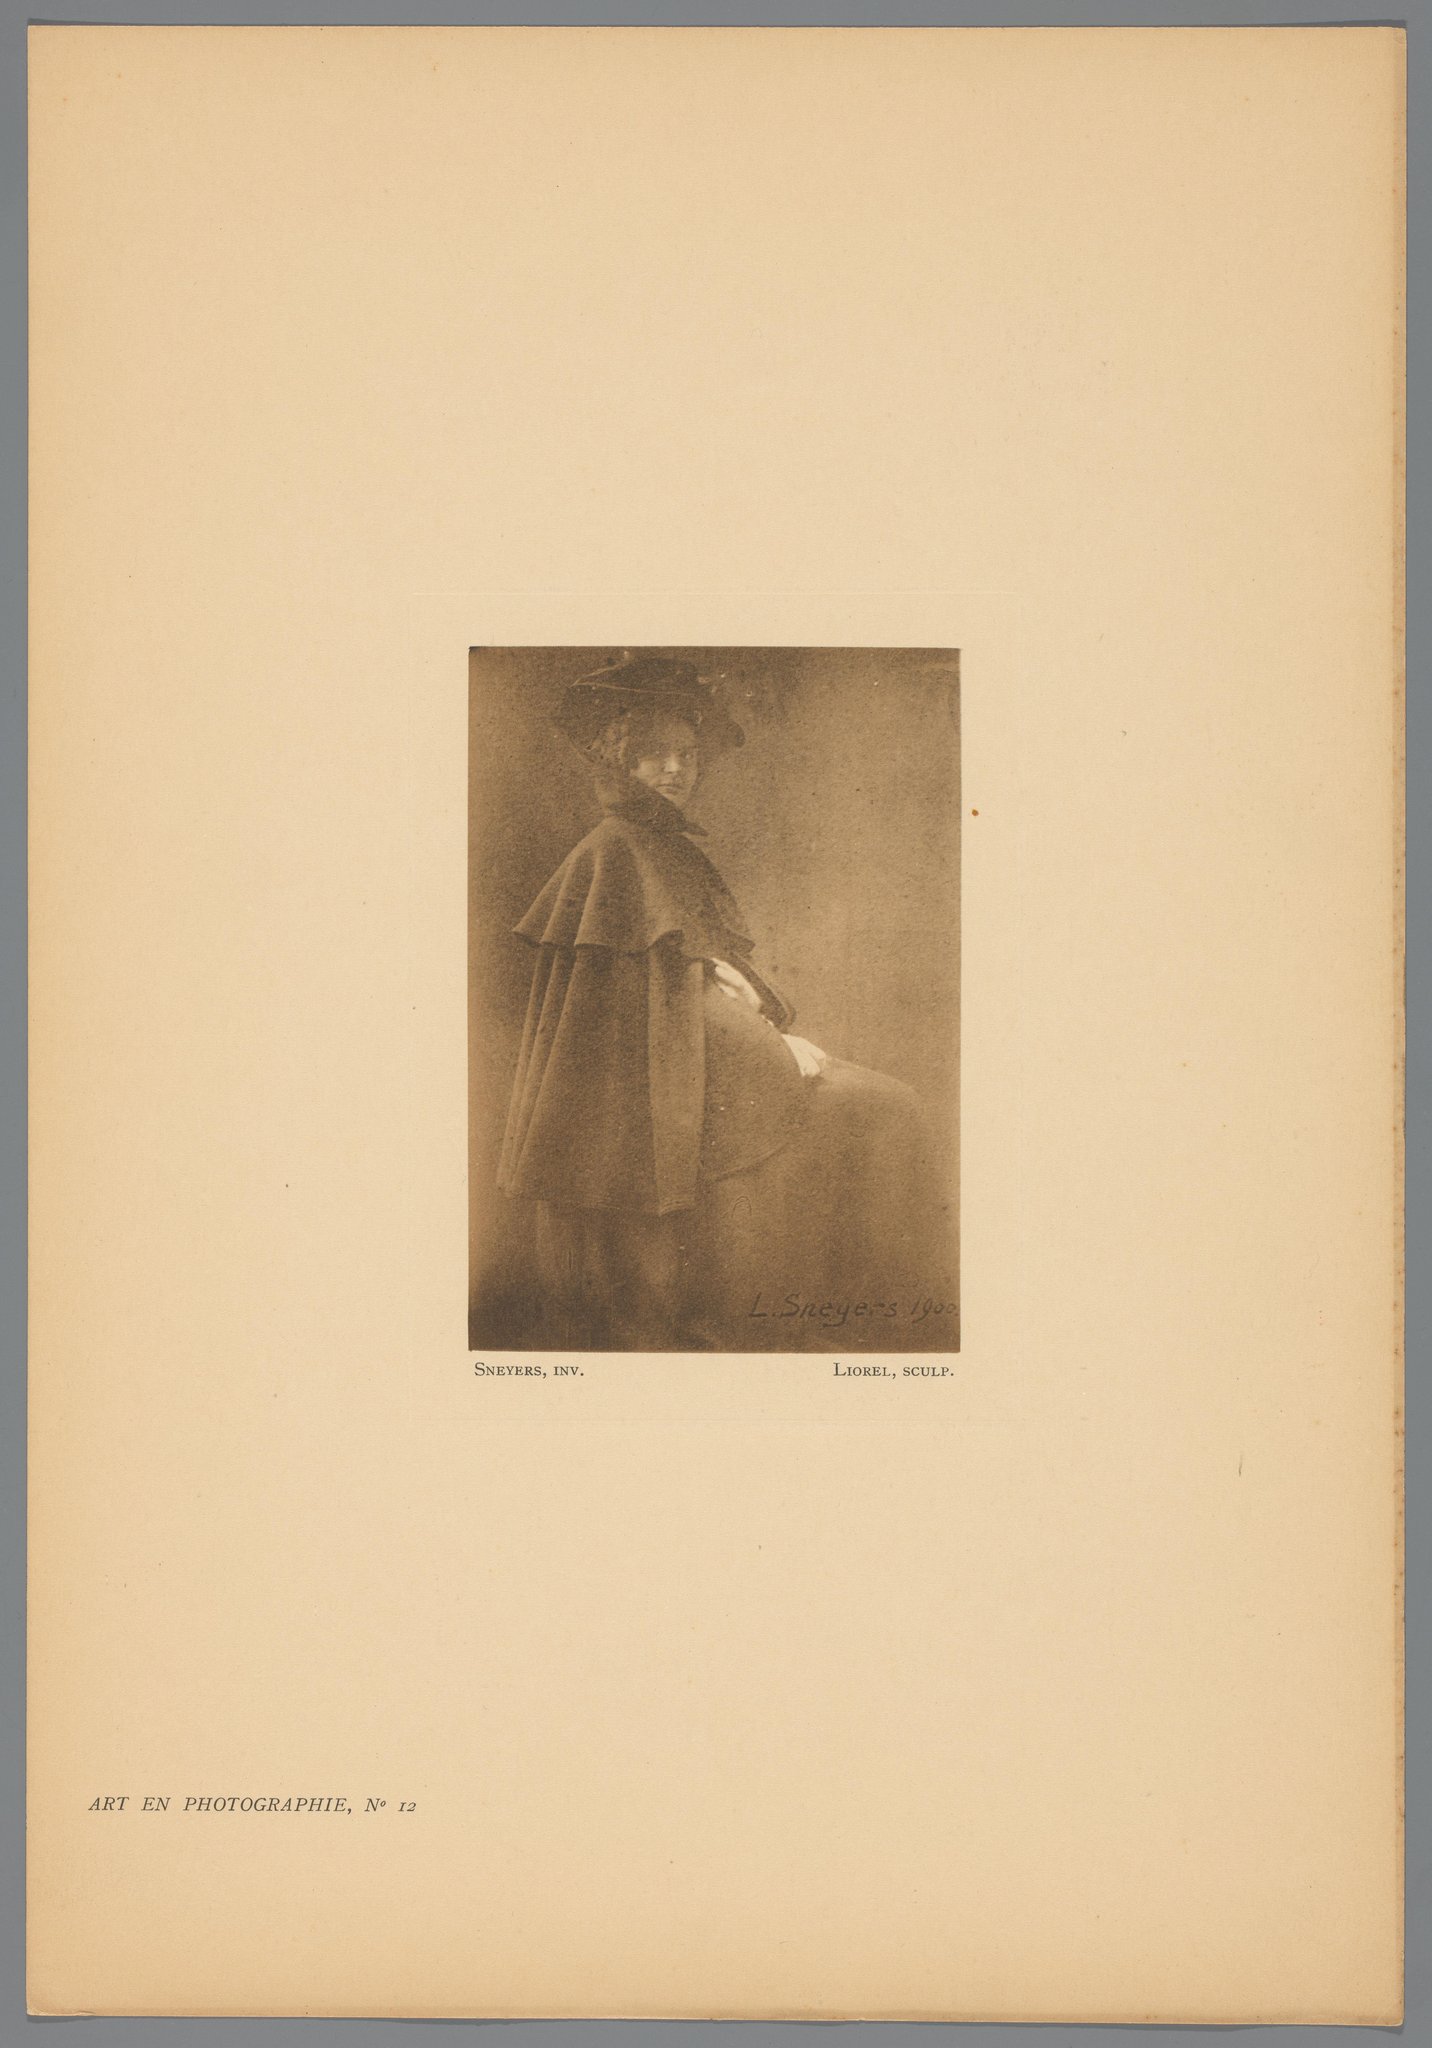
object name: photomechanical print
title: Portret van een onbekende vrouw in een mantel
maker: léon sneyers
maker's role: architect, fotograaf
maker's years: 1877-1949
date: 1900-1901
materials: paper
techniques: photograph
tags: historical persons - bb - woman, coat, cape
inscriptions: inscription: ‘ART EN PHOTOGRAPHIE, No 12’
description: Deze prent maakt deel uit van een omslag met 54 prenten op 52 bladen.